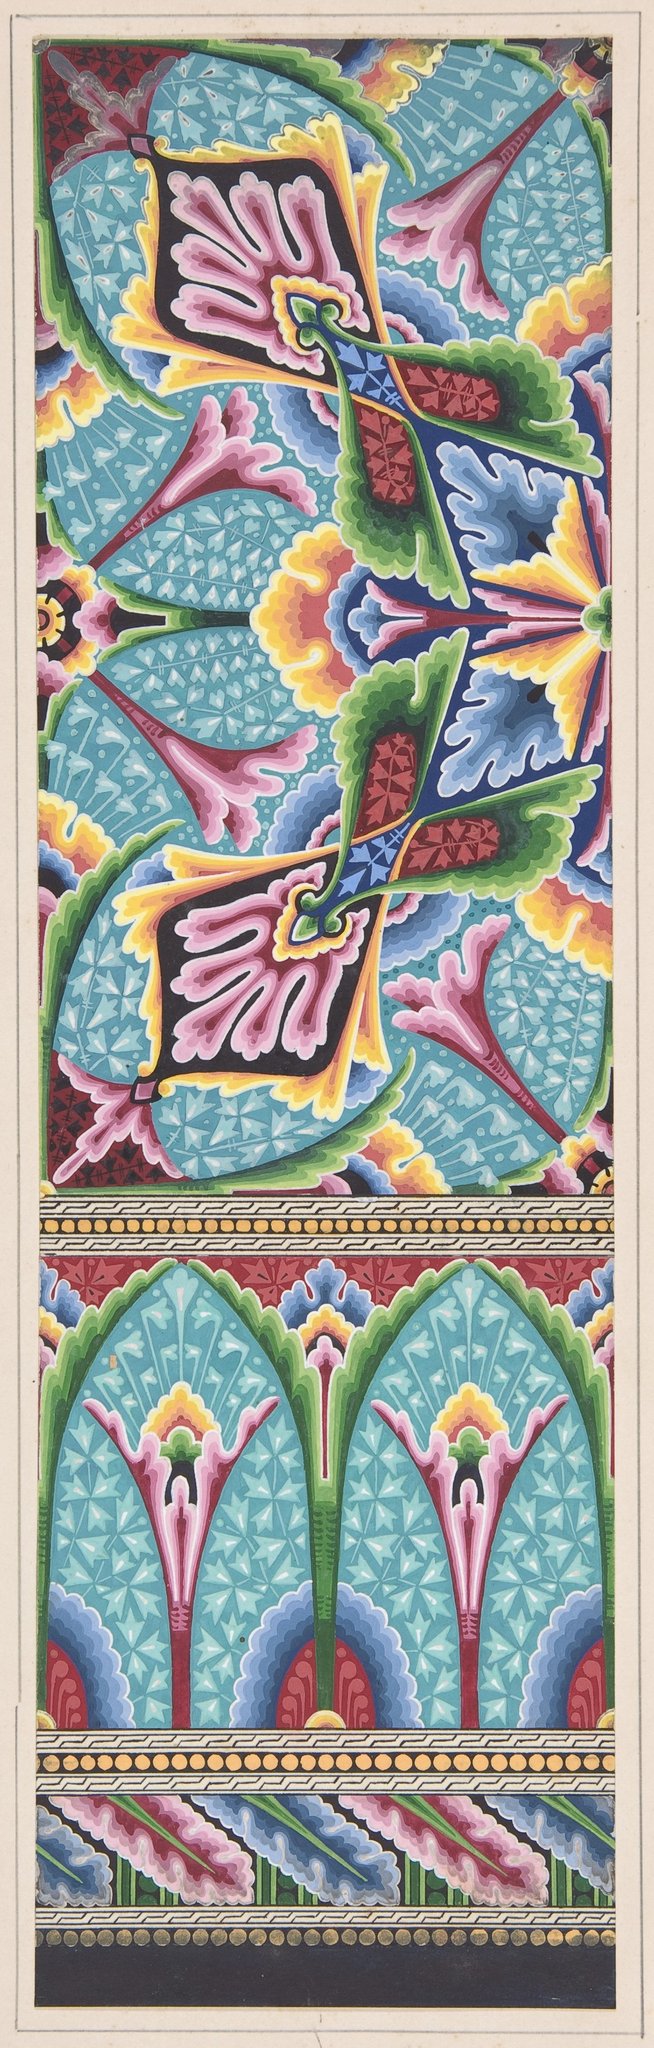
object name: drawing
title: Design drawing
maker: christopher dresser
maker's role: designer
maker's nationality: british, scottish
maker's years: 1834-1904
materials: gouache, graphite, ink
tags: ornament